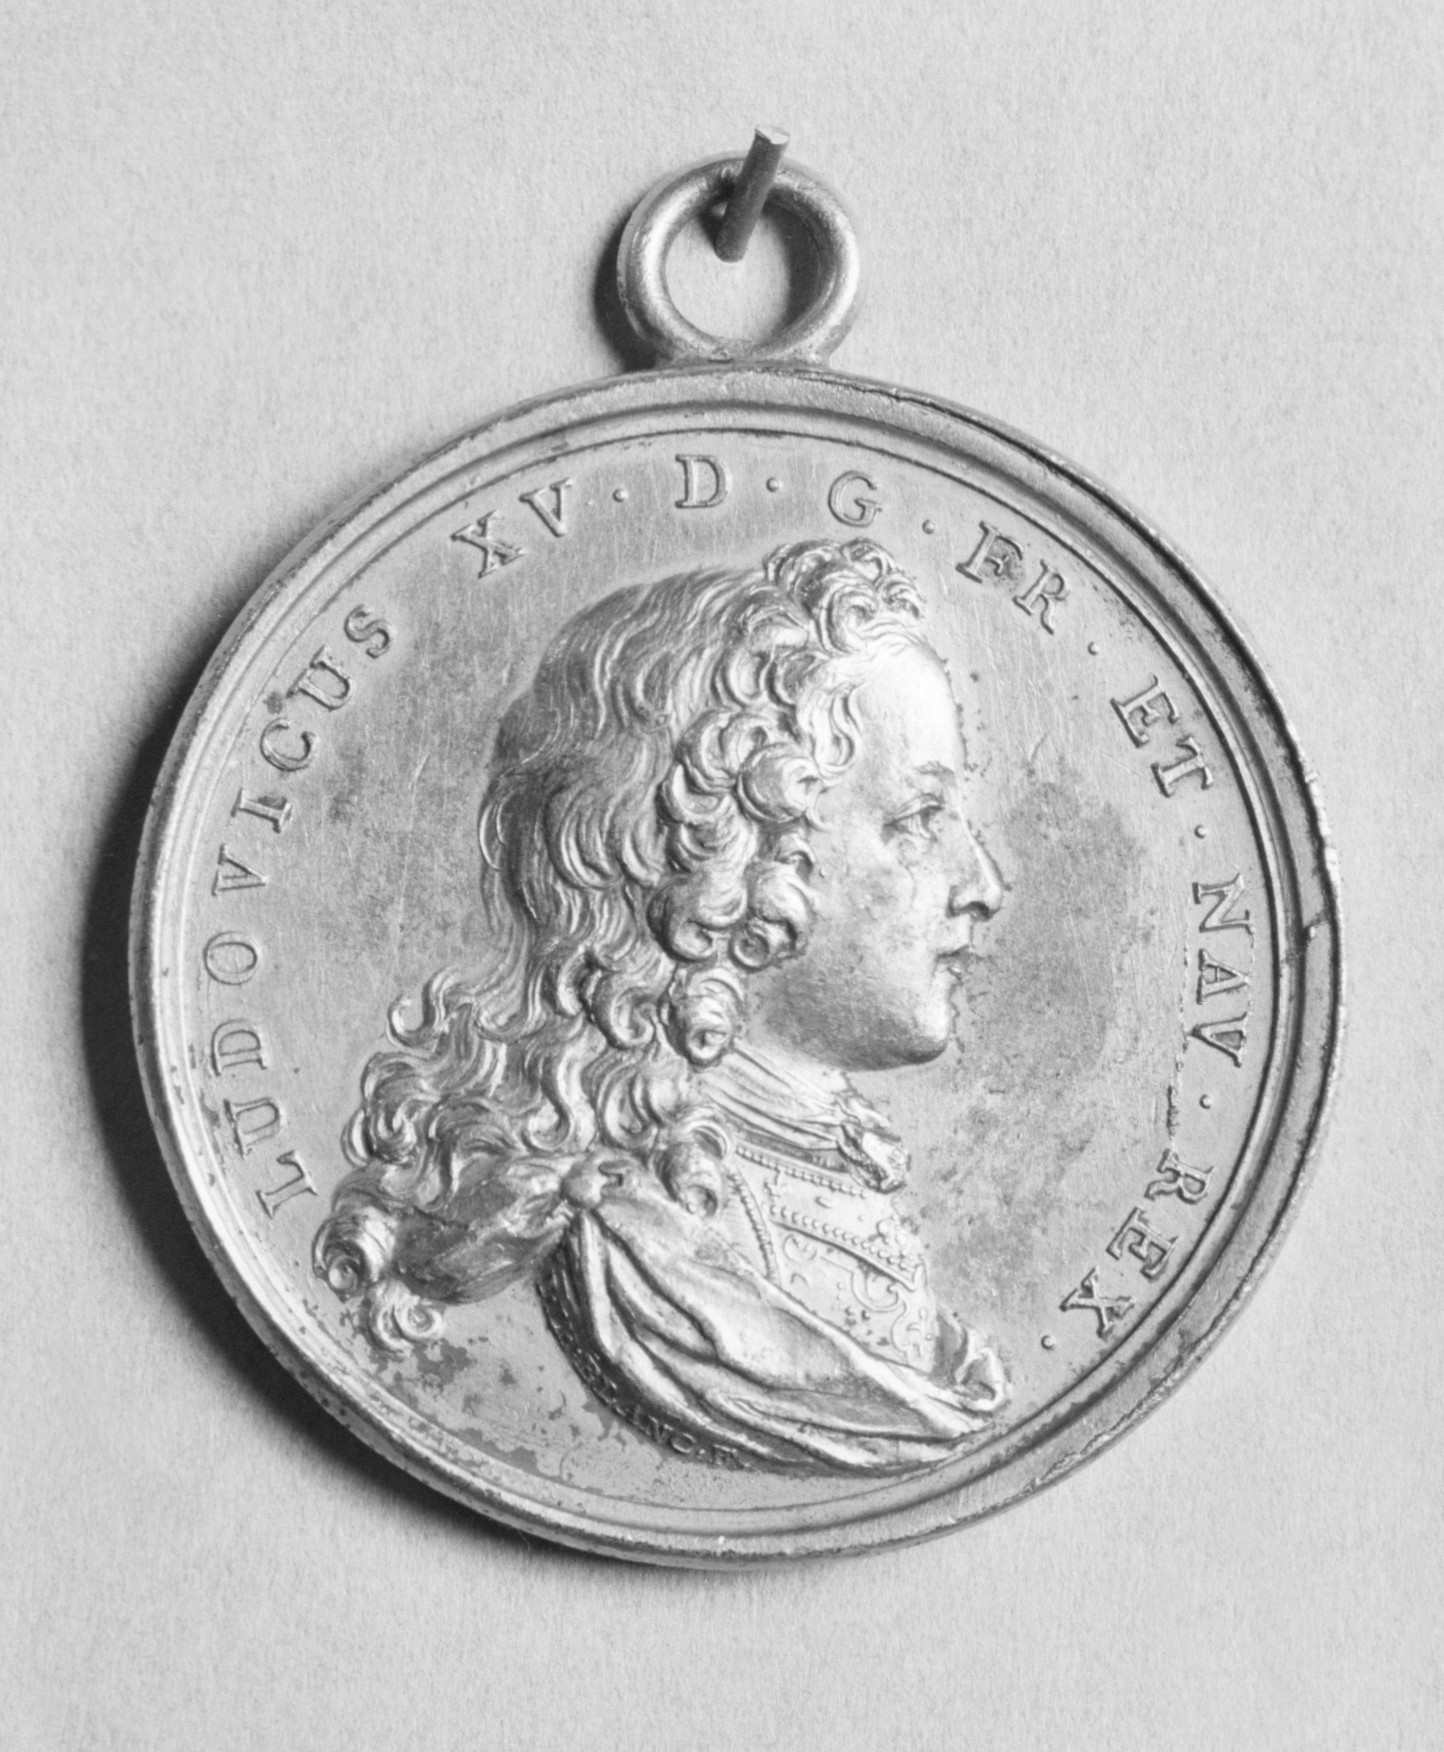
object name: medal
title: Louis XV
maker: jean le blanc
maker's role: artist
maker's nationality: french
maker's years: 1676-1749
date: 1715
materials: gilt bronze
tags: men,profiles